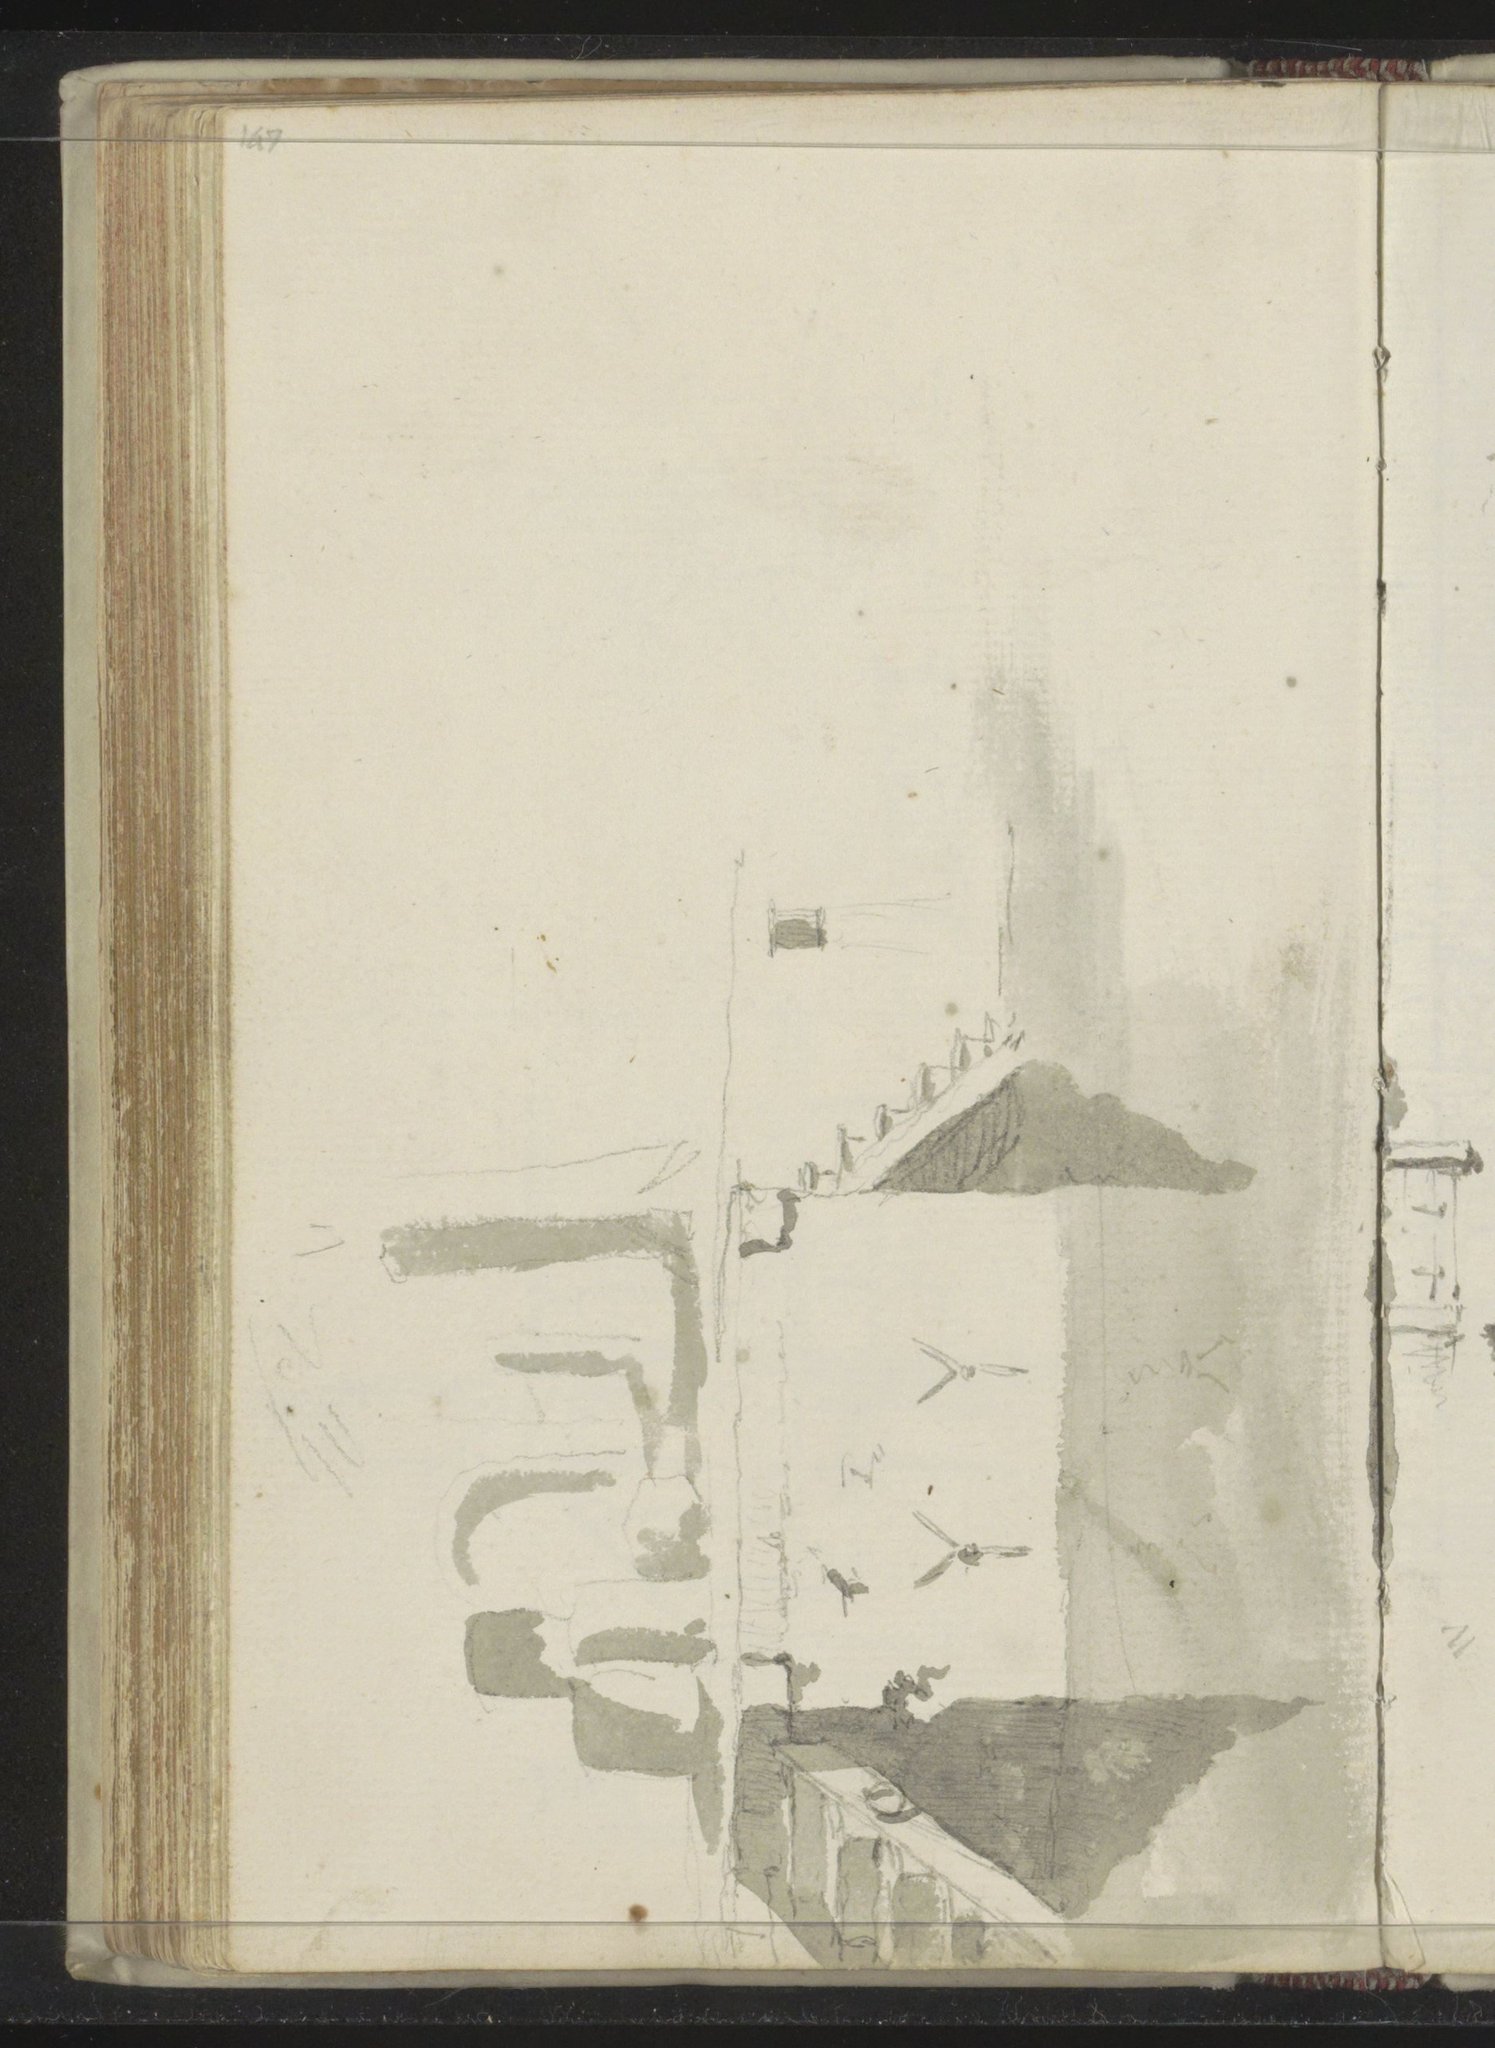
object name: sketchbook leaf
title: Kadetrappen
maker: johannes huibert prins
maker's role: draughtsman, painter, print maker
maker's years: 1757-1806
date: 1783-1797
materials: paper, pencil, watercolor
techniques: brush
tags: flight of steps, pier, quay, wharf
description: Pagina 147 uit een schetsboek met 175 pagina's.